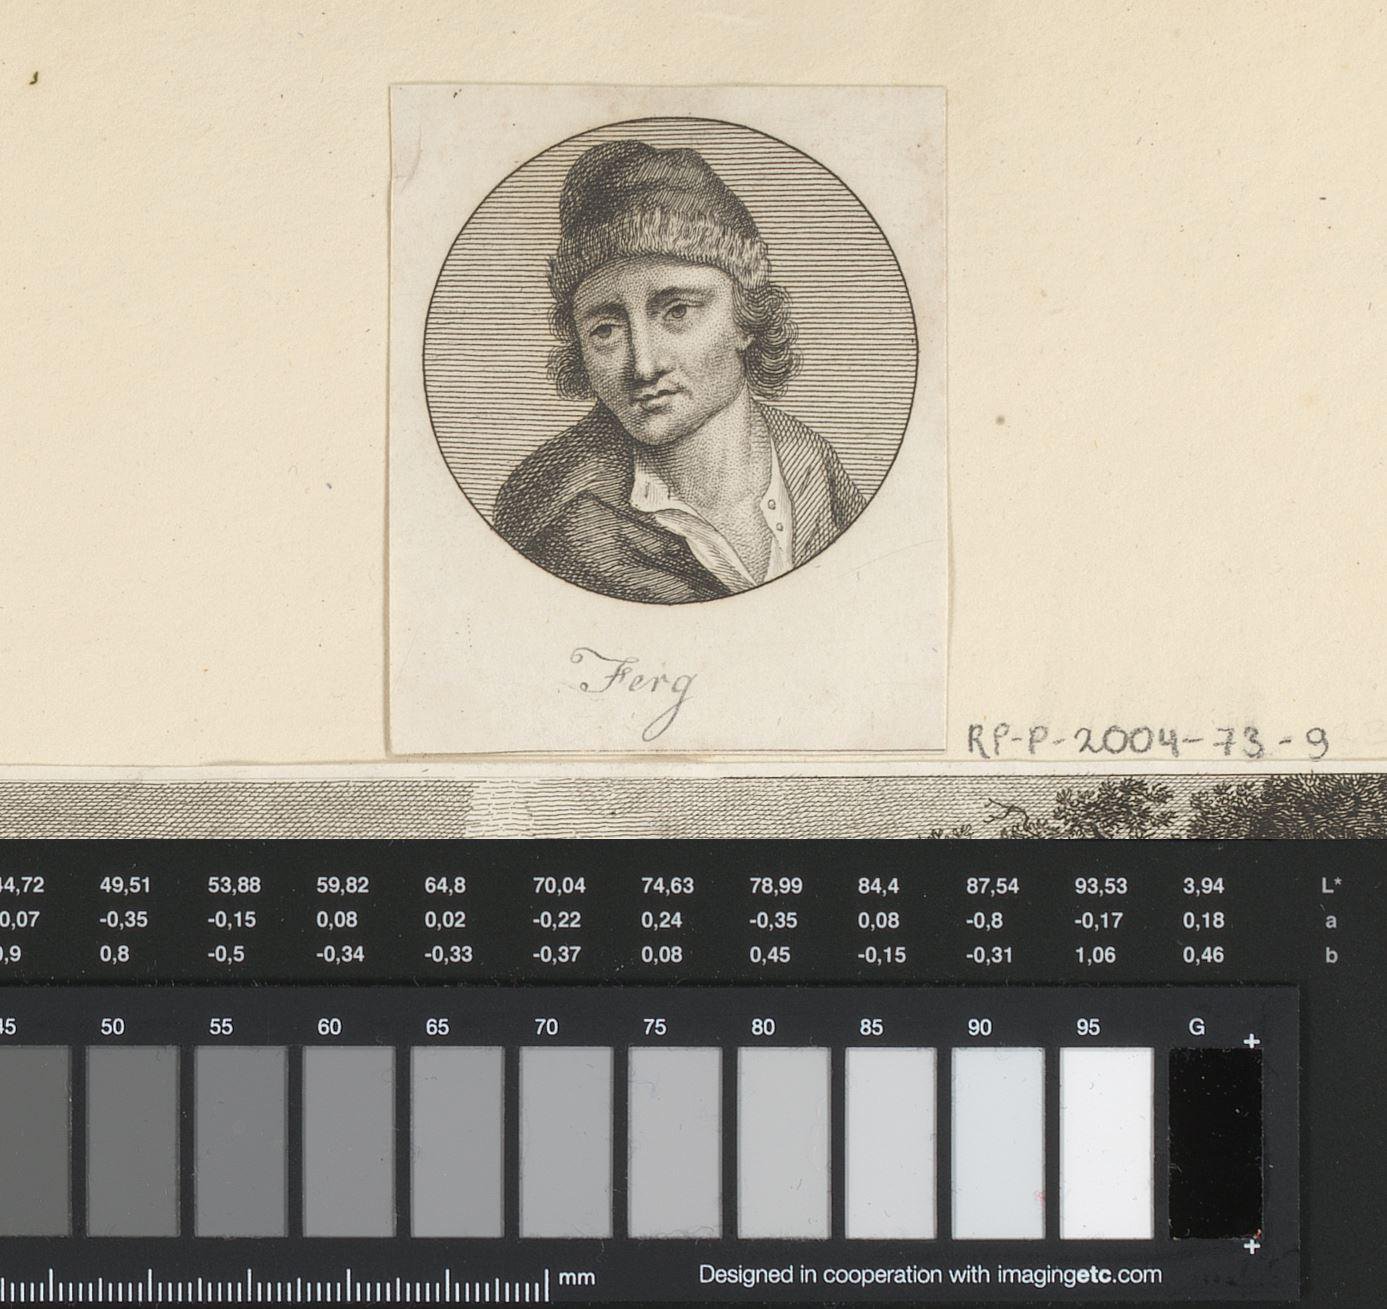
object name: print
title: Portret van Franz de Paula Ferg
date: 1791-1800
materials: paper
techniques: engraving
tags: vienna, london, painter, draughtsman, franz de paula ferg, historical persons, portrait, self-portrait of painter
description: De samensteller heeft deze prent in het album geplakt als illustratie bij: Pilkington, Matthew en Johann Heinrich Füssli. A dictionary of painters, from the revival of the art to the present period. 4 dln. Londen: John Crowder, 1805, dl. 2, p. 184.